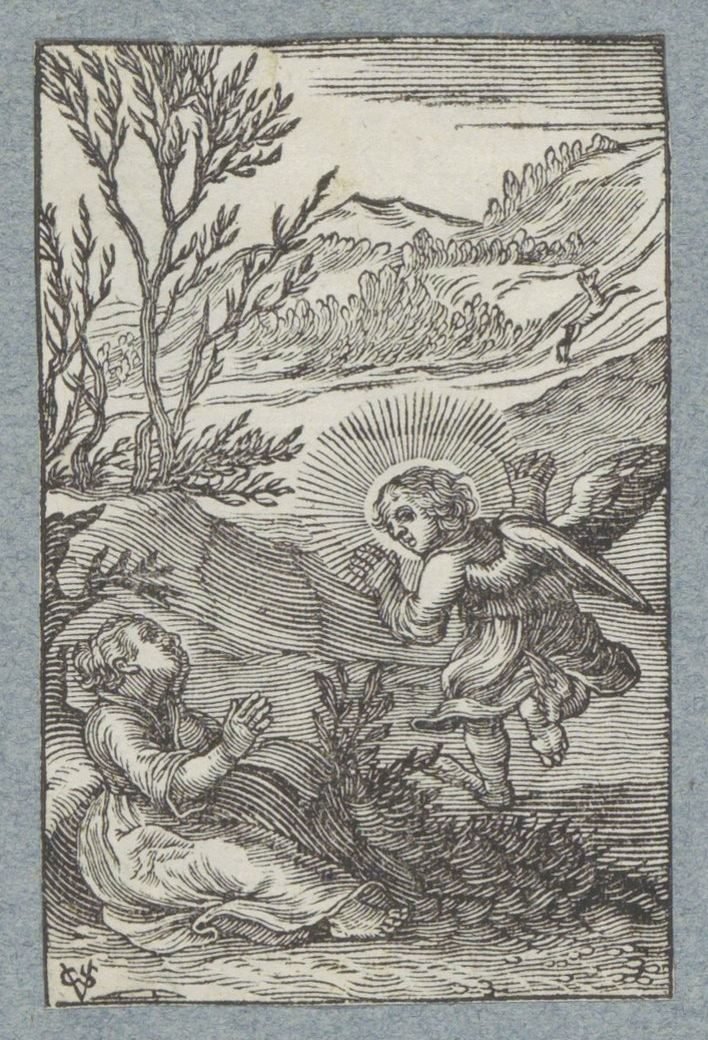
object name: album leaf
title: Engel sluipt weg van slapend kind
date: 1628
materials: paper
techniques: woodcut, pasting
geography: antwerp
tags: flight, running away; pursuing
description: Prent uit: Herman Hugo, Pia desideria emblematis, elegiis & affectibus S. S. Patrum illustrata, Antwerpen 1628. Volgens de titelpagina verscheen dit werk in Antwerpen bij Hendrick Aertssens, in werkelijkheid verscheen het in Amsterdam bij Pieter Jacobsz Paets (Dietz 2012, p. 58-59).